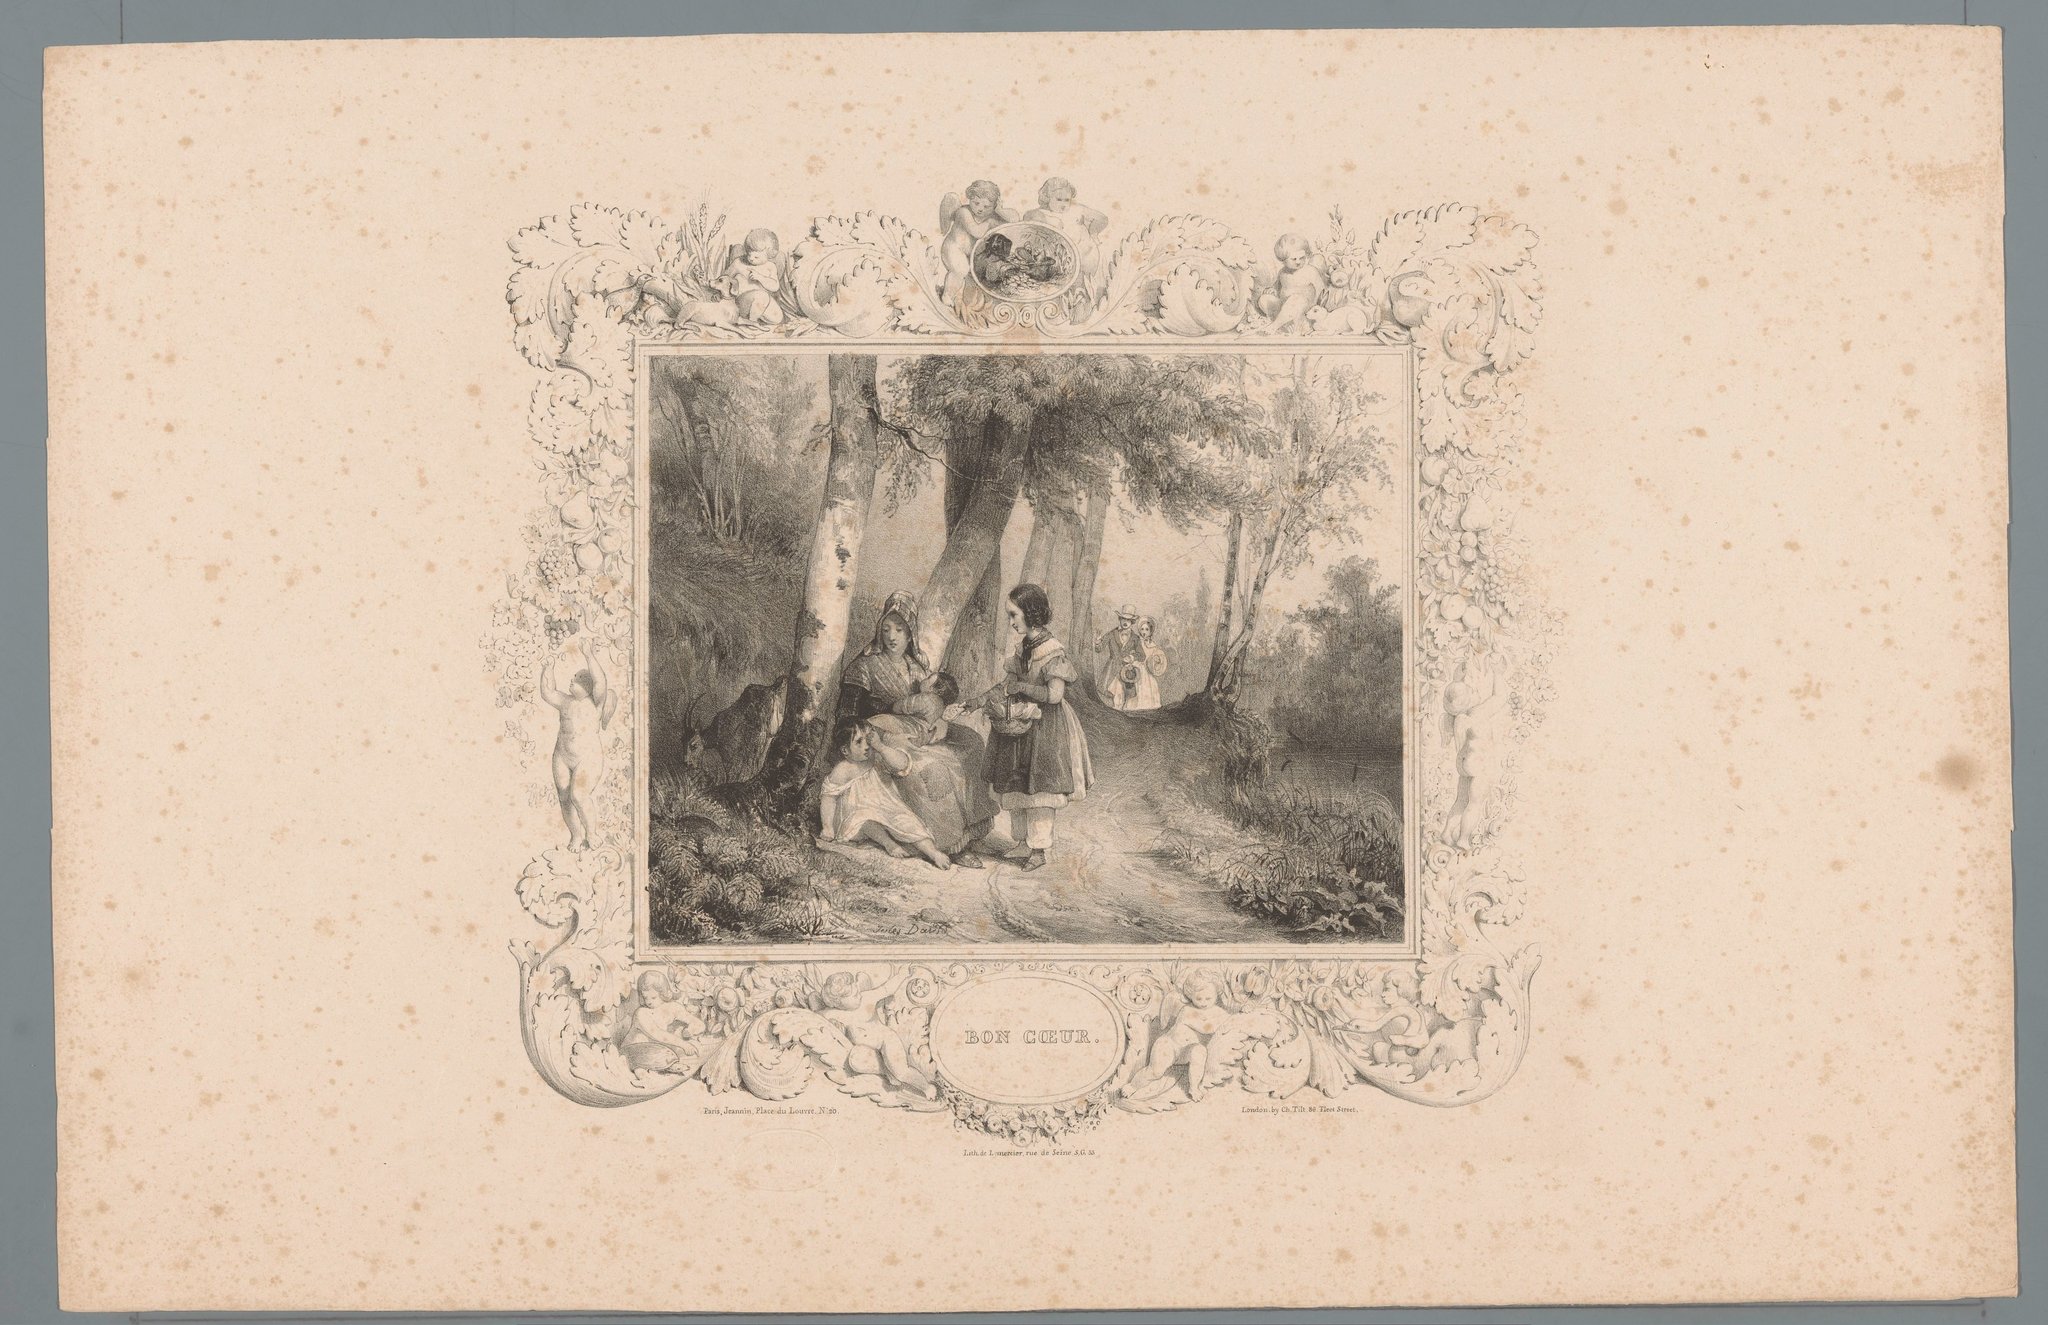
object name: print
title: Bon coeur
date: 1836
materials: paper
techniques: lithograph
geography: paris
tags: giving alms or other charity, e.g.: handing out food, girl (child between toddler and youth), road, path, mother and baby or young child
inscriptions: collector's mark: Lugt 2228a, check stamp: Lugt 1397c